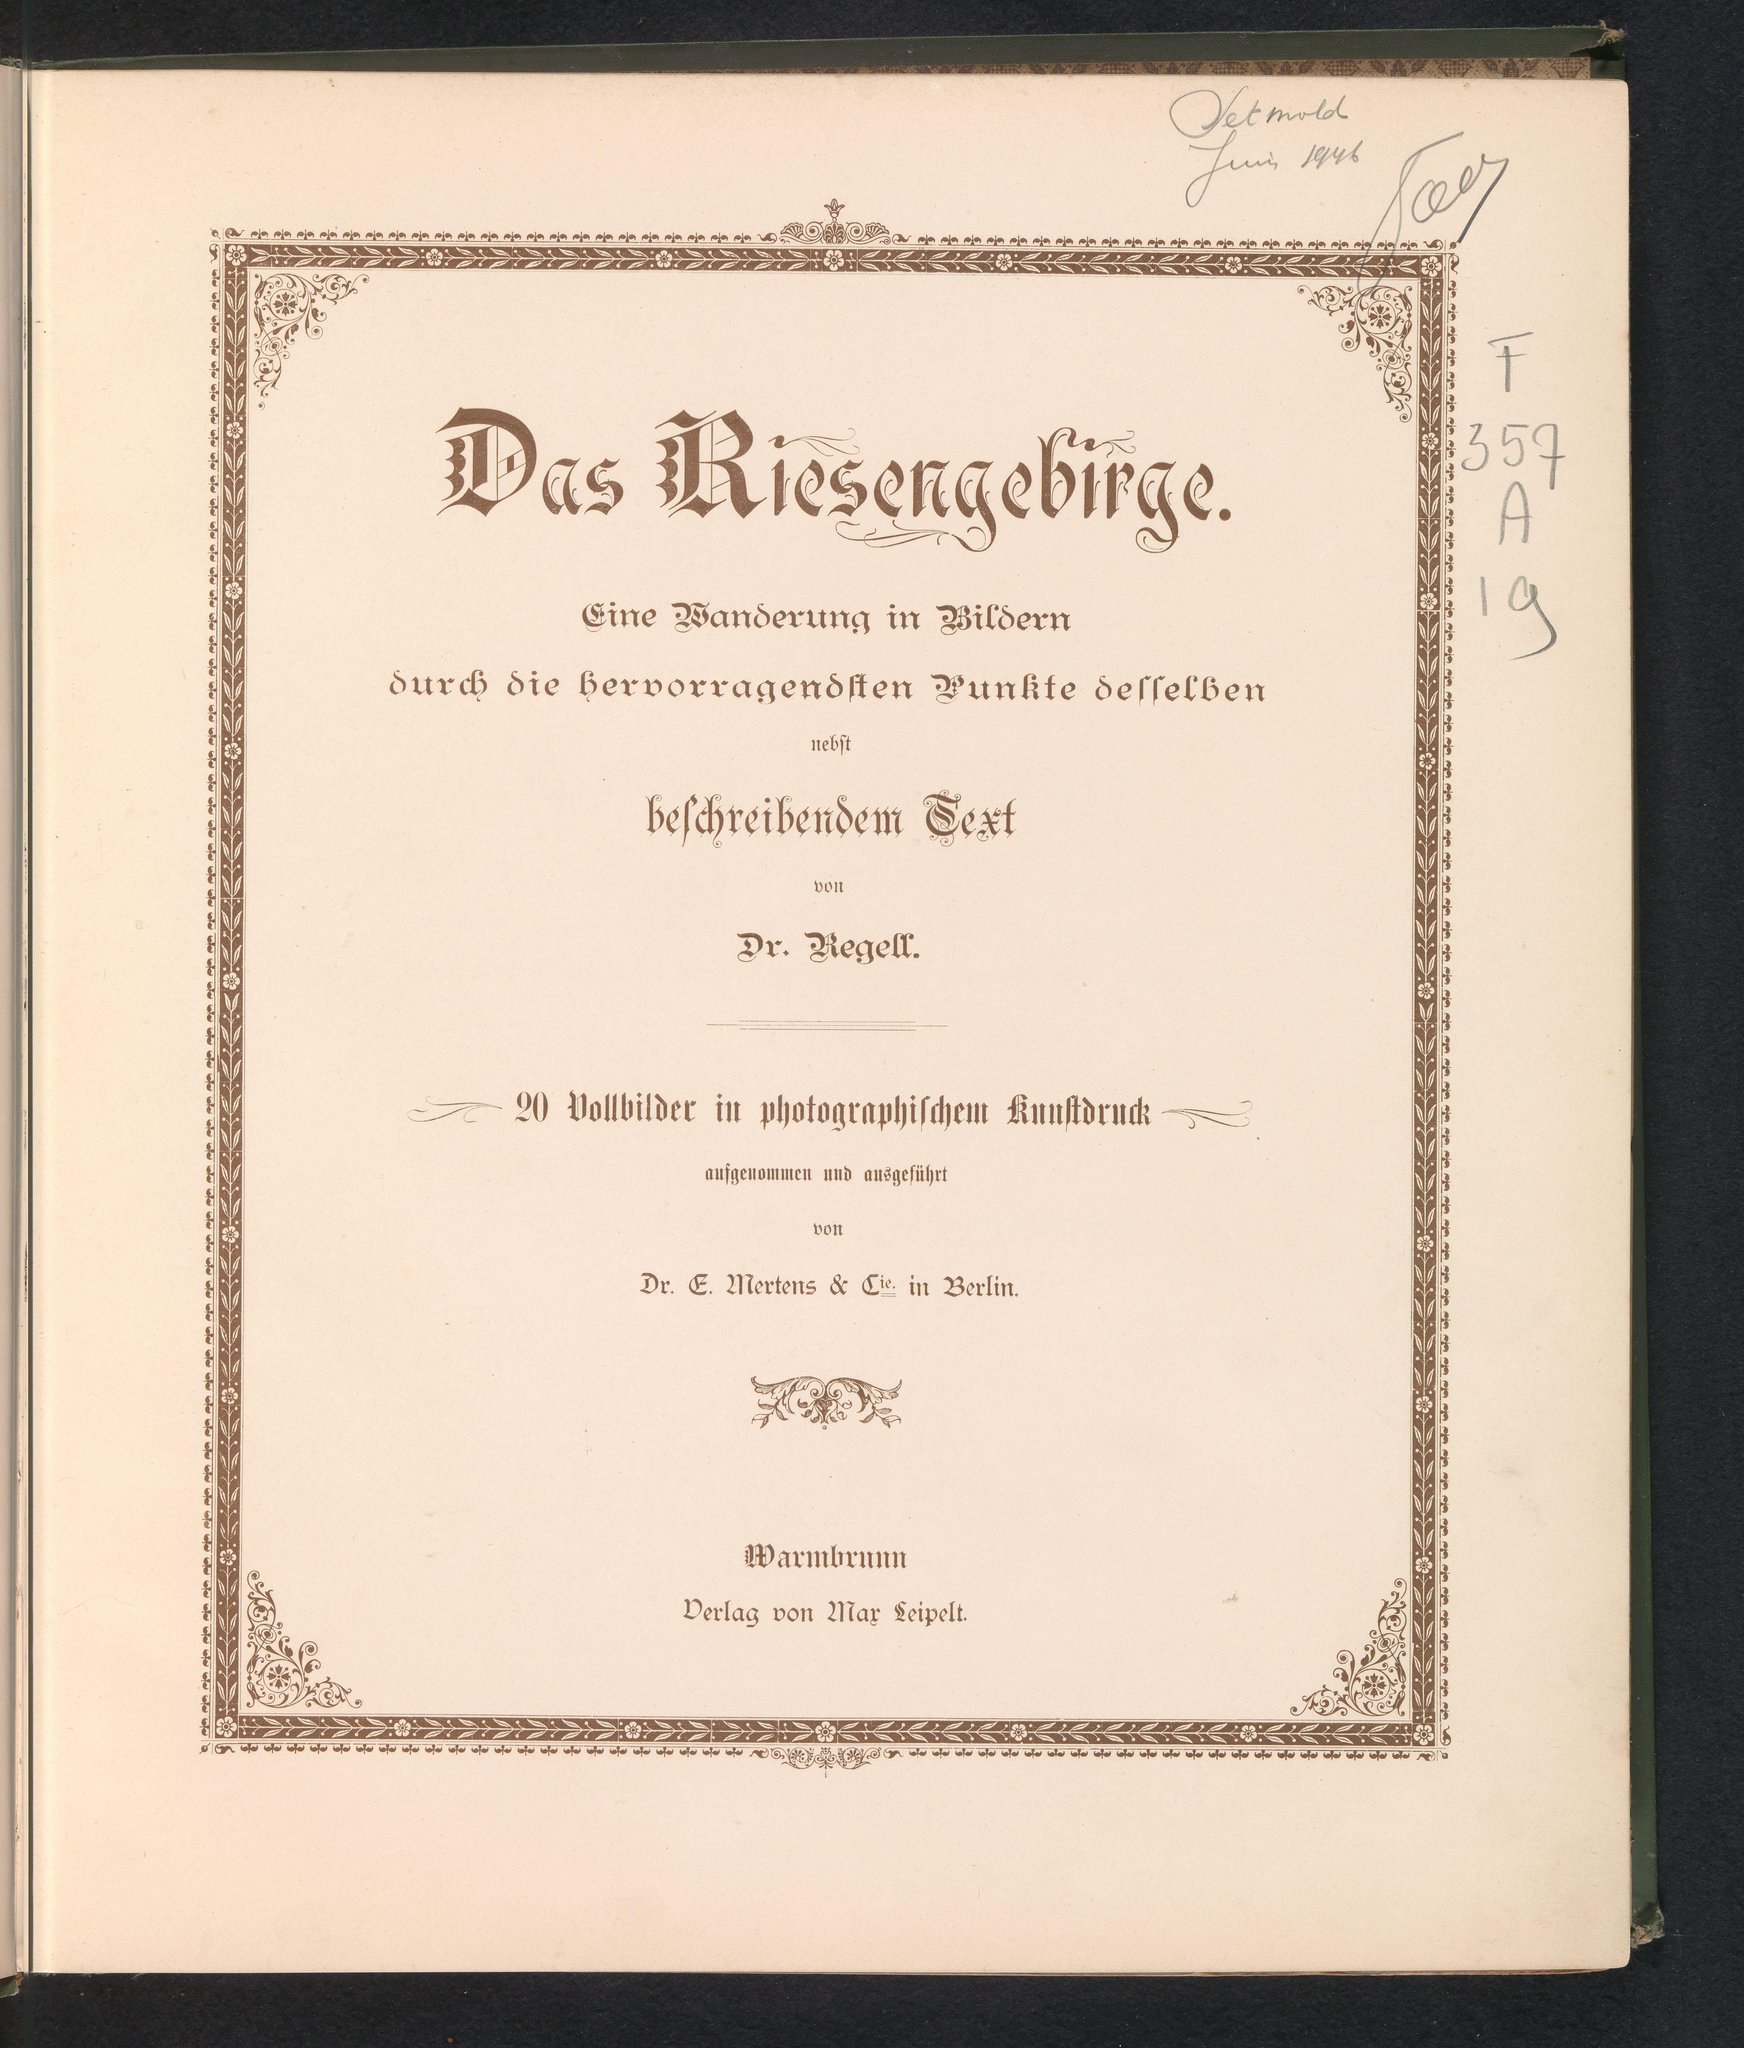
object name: book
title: Das Riesengebirge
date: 1892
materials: cardboard, linen, paper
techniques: photograph, printing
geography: warmbrunn